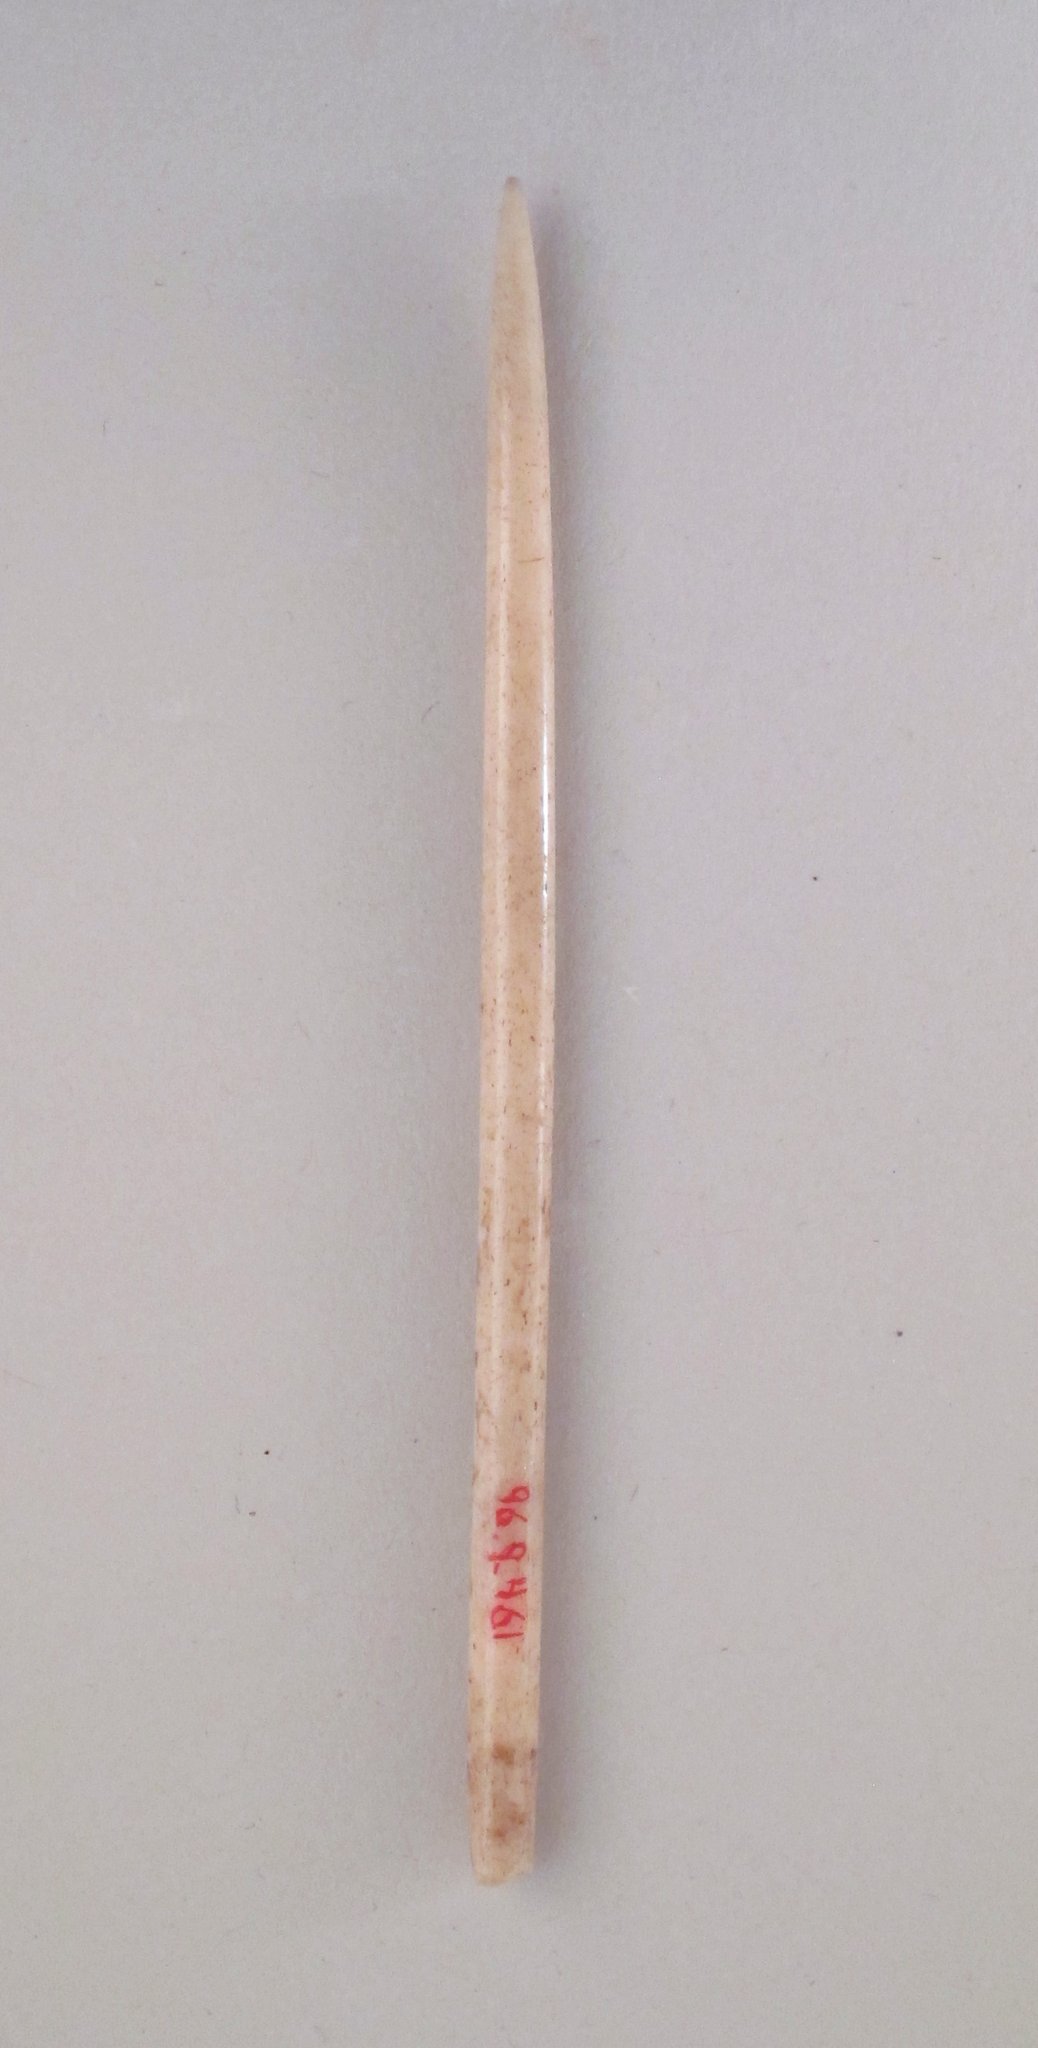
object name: stylus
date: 7000 BCE-330 CE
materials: bone, ivory